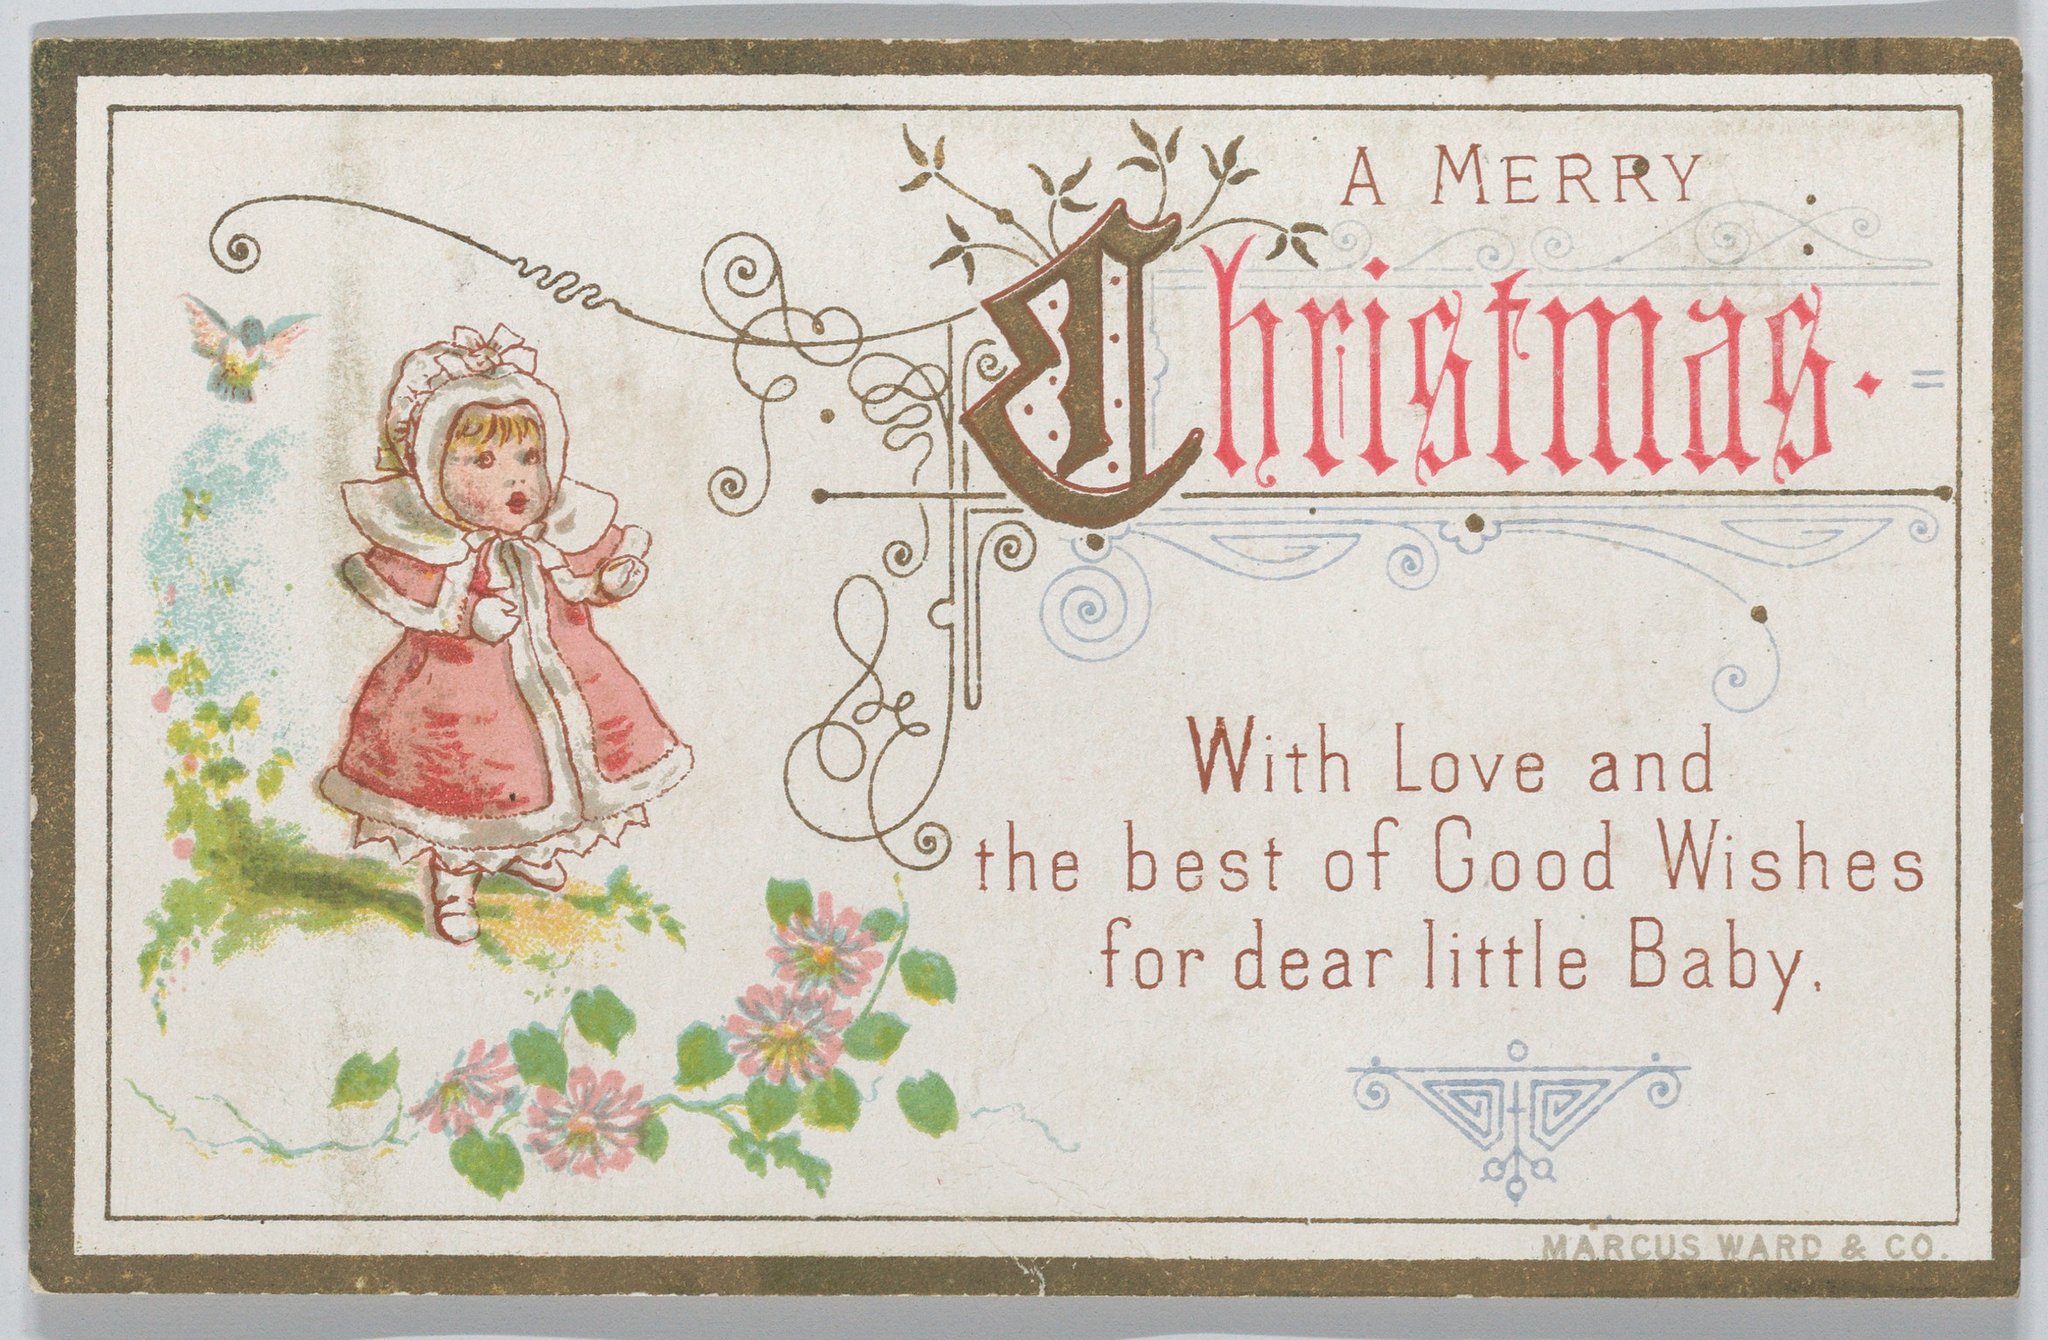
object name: valentine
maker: Anonymous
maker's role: artist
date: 1877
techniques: chromolithography